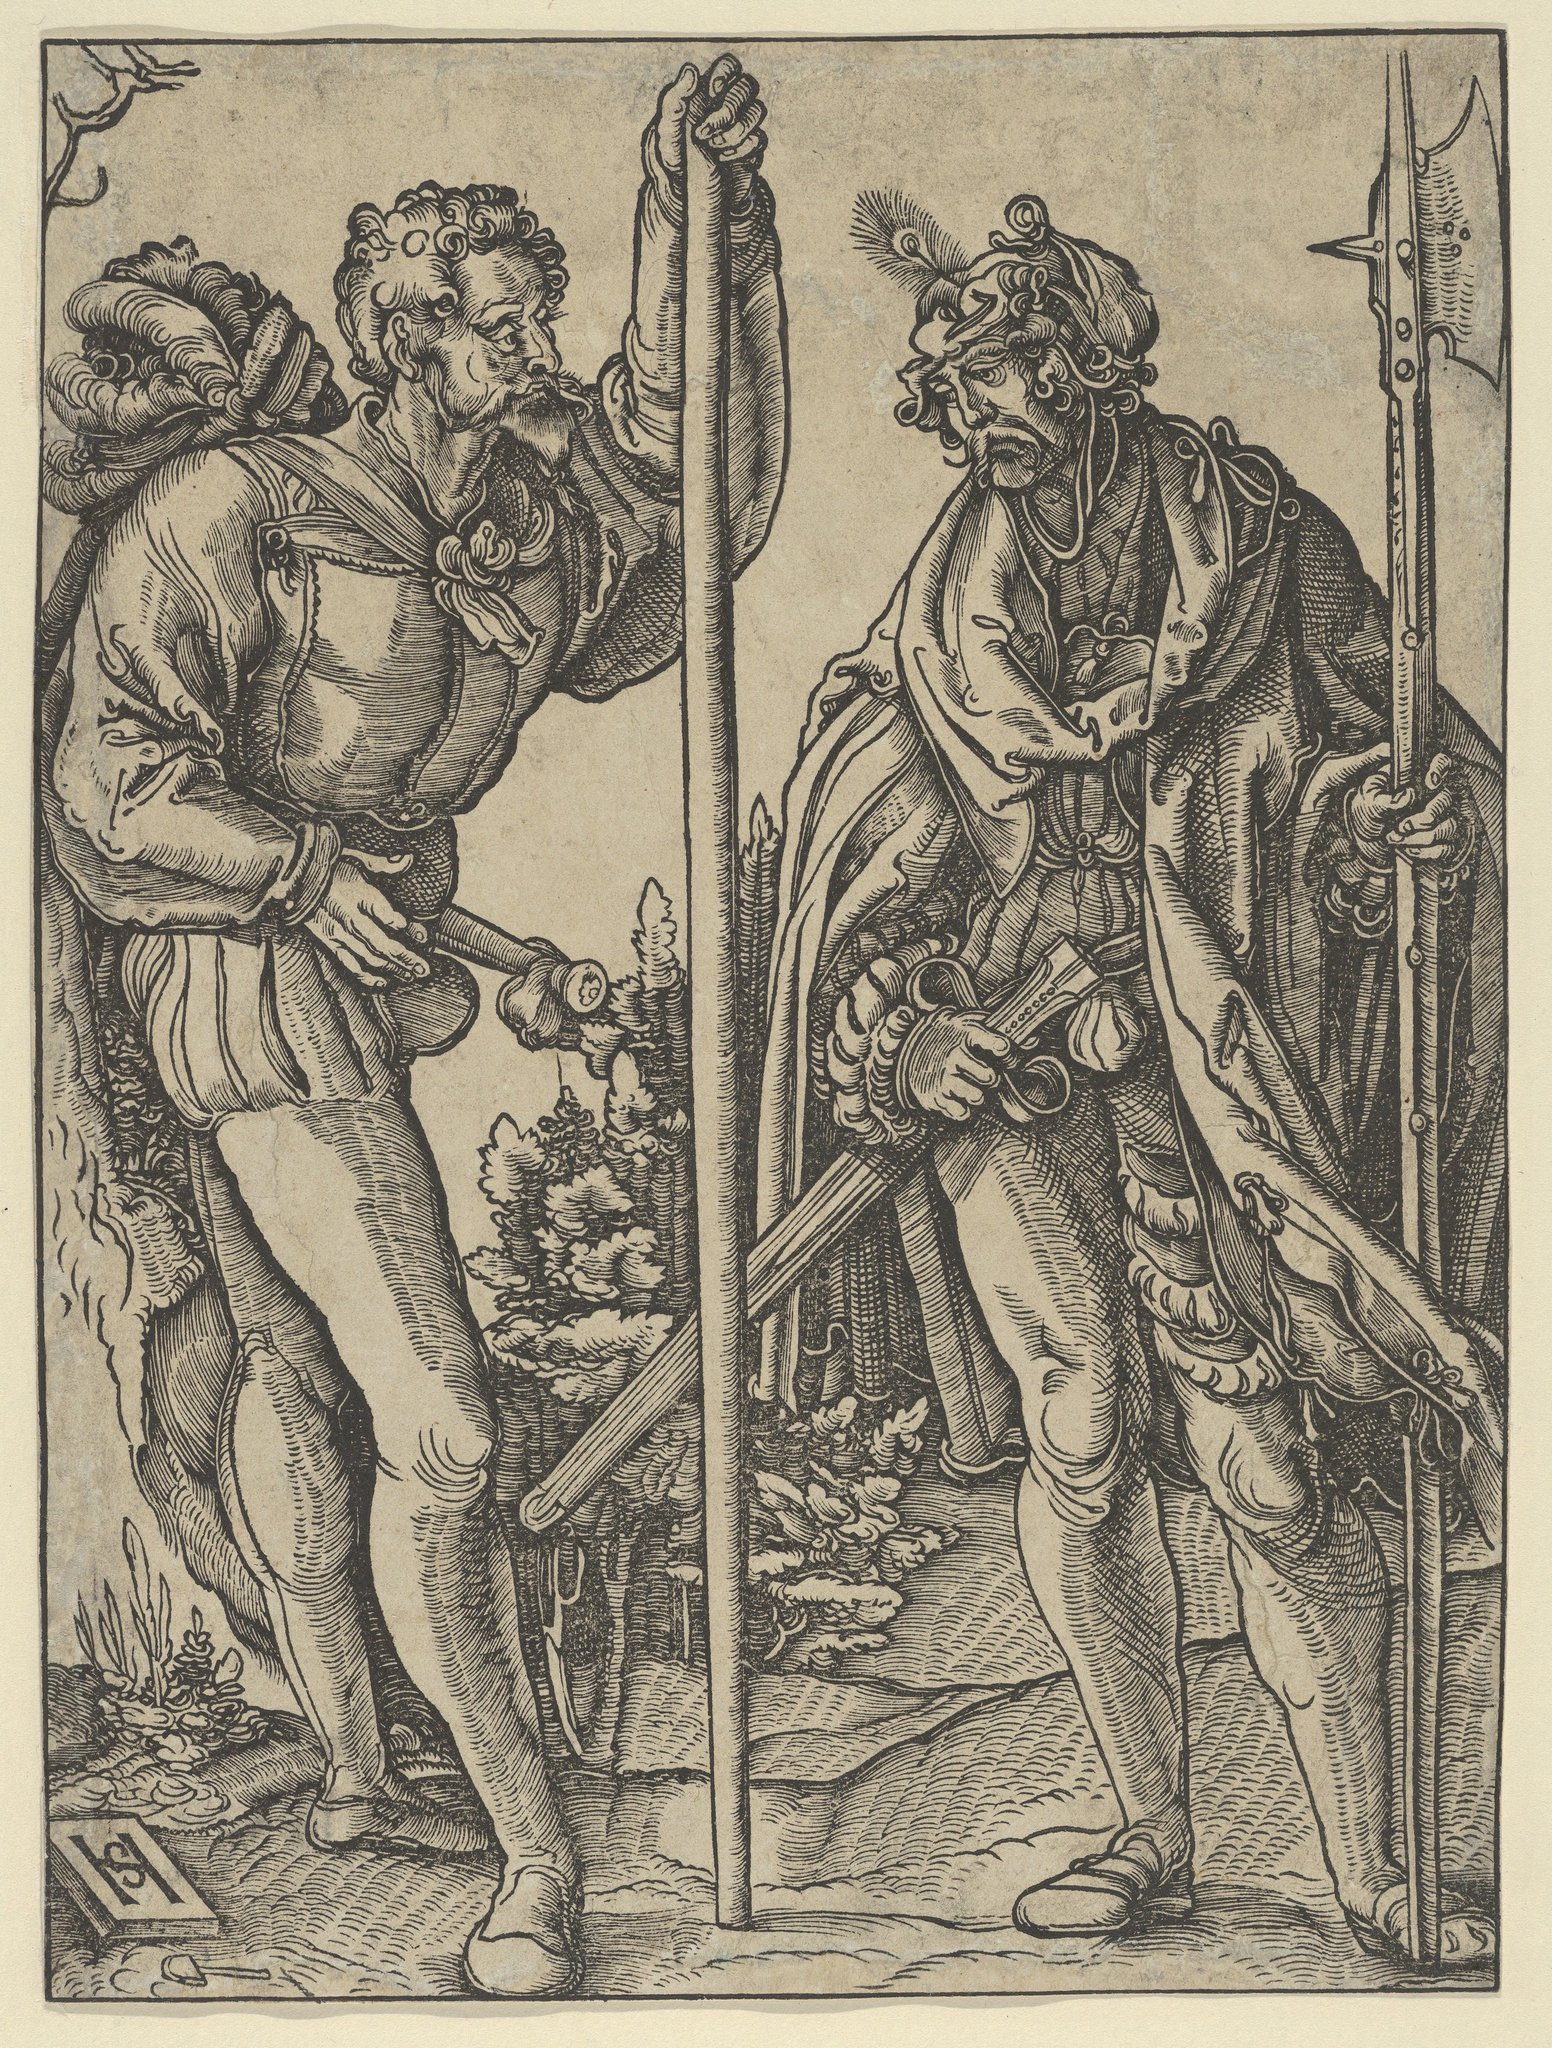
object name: print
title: Two Soldiers with Lance and Halberd Conversing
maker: hans schäufelein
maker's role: artist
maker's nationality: german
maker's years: 1480-1540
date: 1515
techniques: woodcut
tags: soldiers,weapons